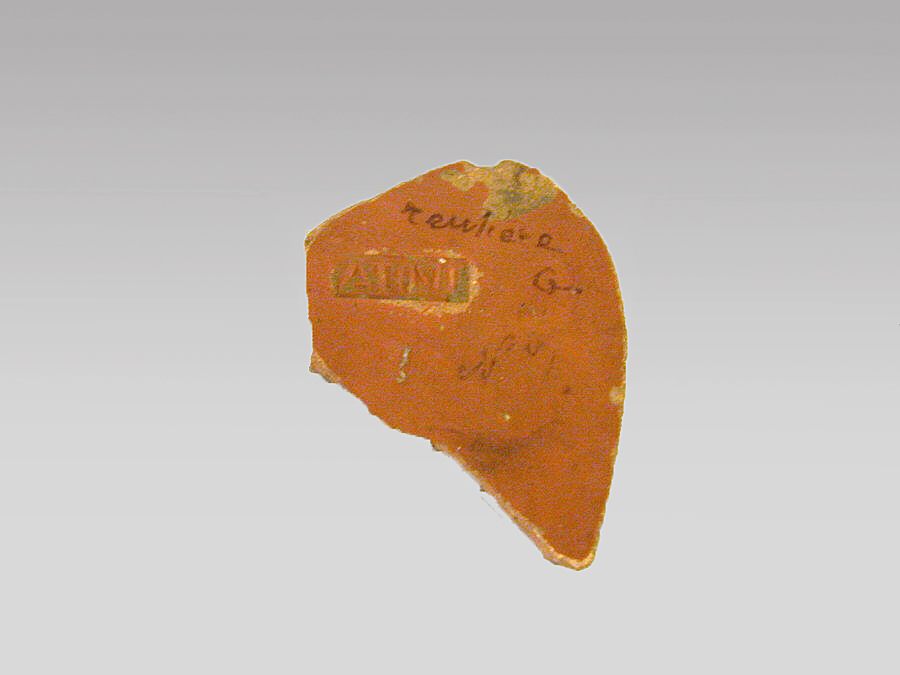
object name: vase fragment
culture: roman, gaul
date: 120 BCE-300 CE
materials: terracotta